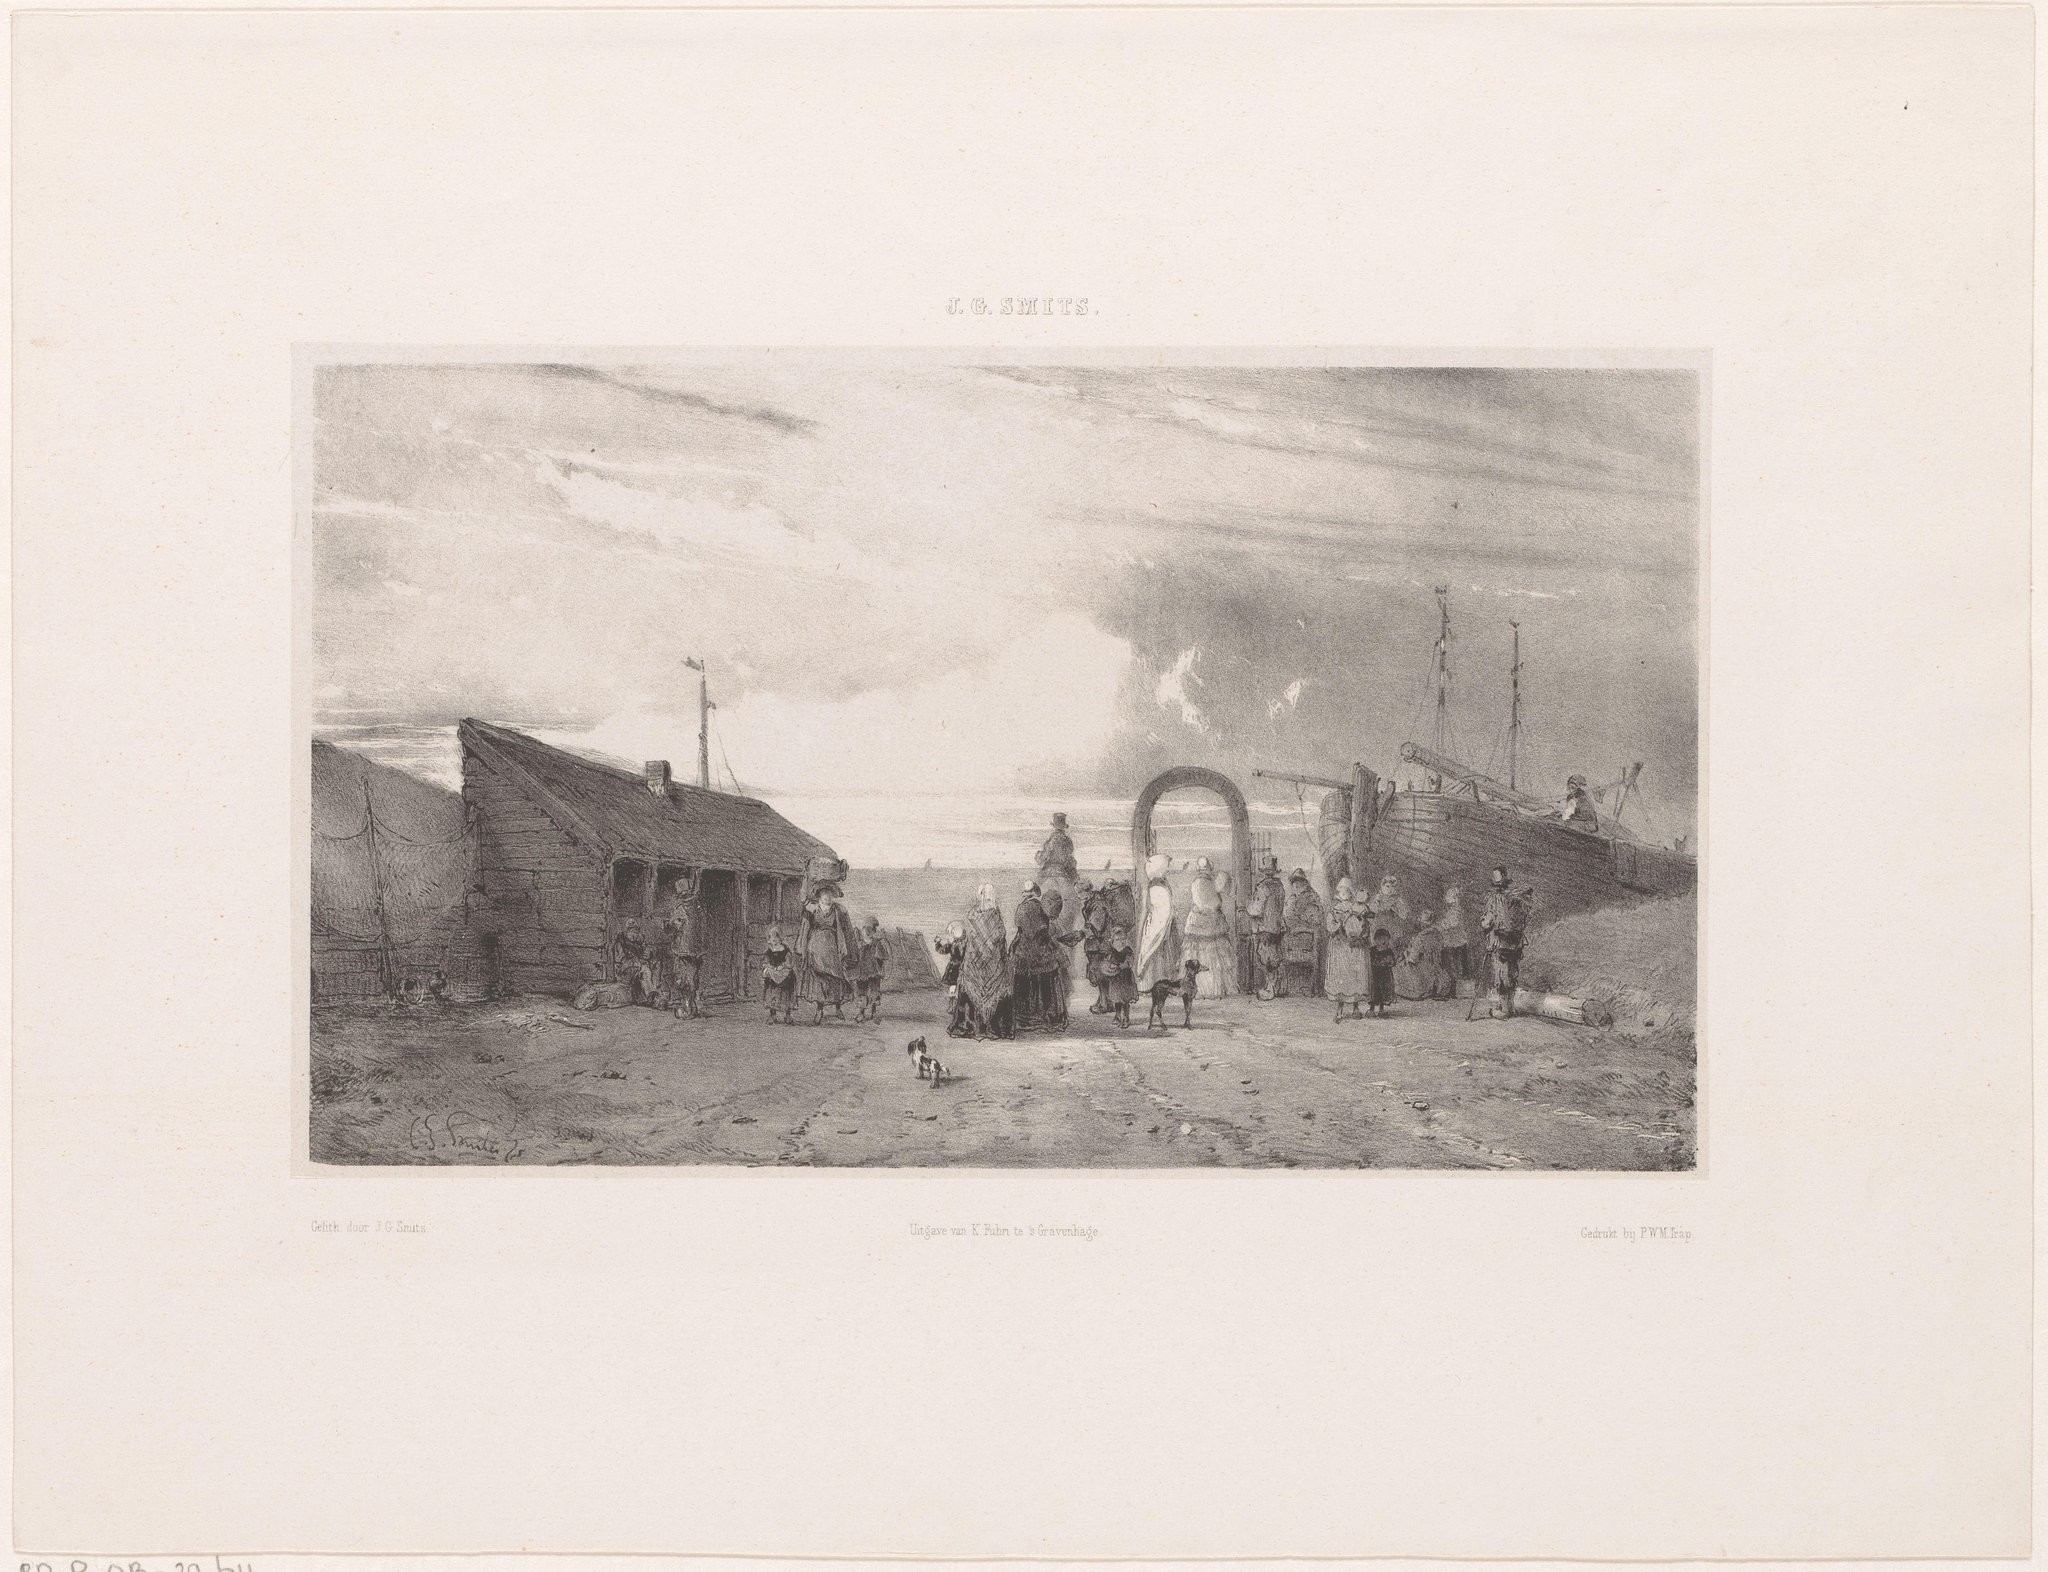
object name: print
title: Mensen in een haven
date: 1838-1855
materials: paper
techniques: lithograph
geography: the hague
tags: harbour, sailing-ship, sailing-boat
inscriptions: collector's mark: Lugt 2228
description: Een groep mensen staat in een haven. Rechts ligt een aangemeerde zeilboot.